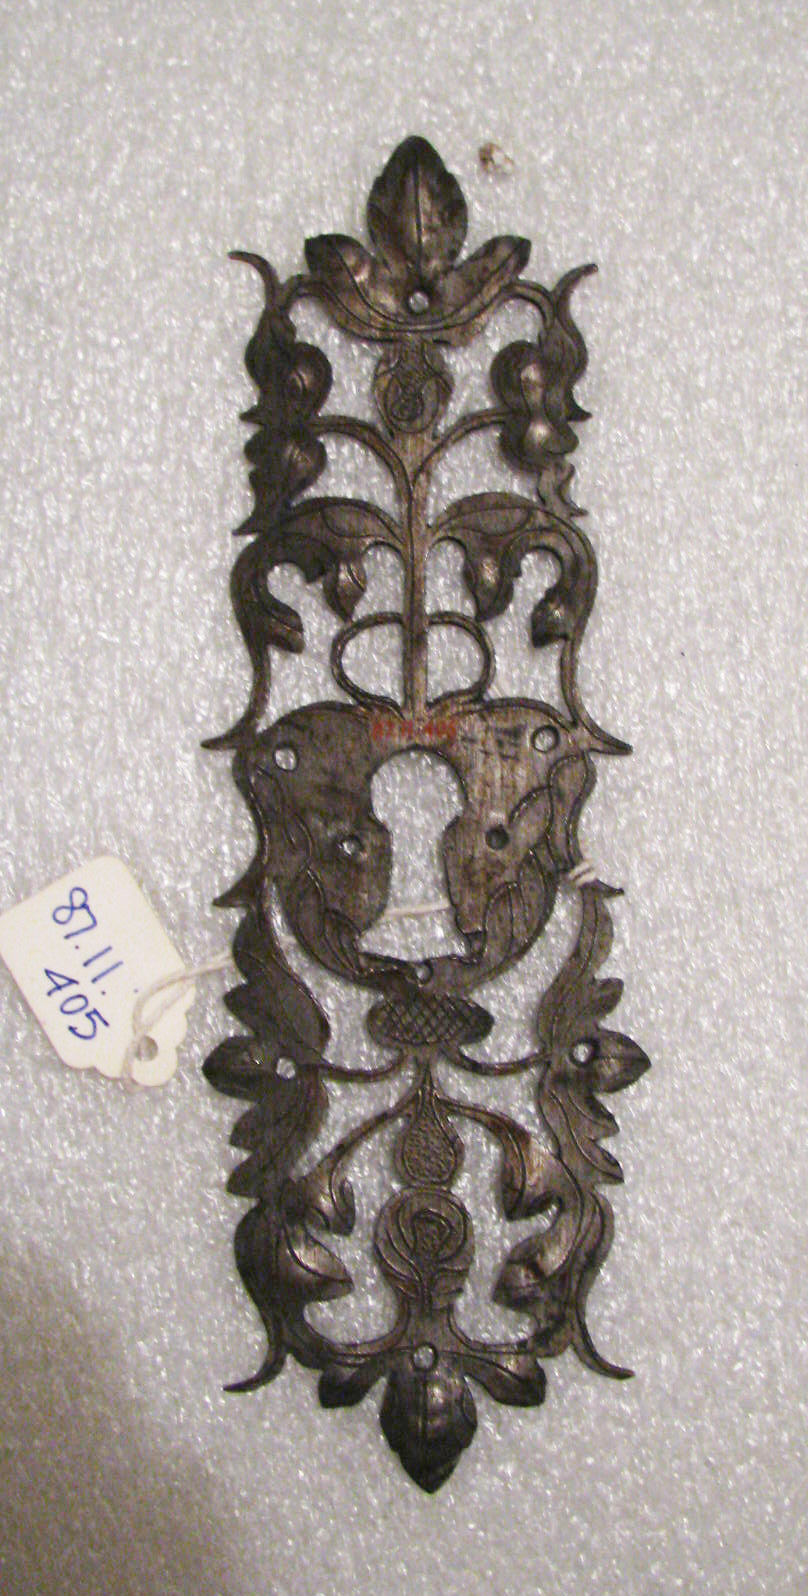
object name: escutcheon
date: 1601-1700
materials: iron